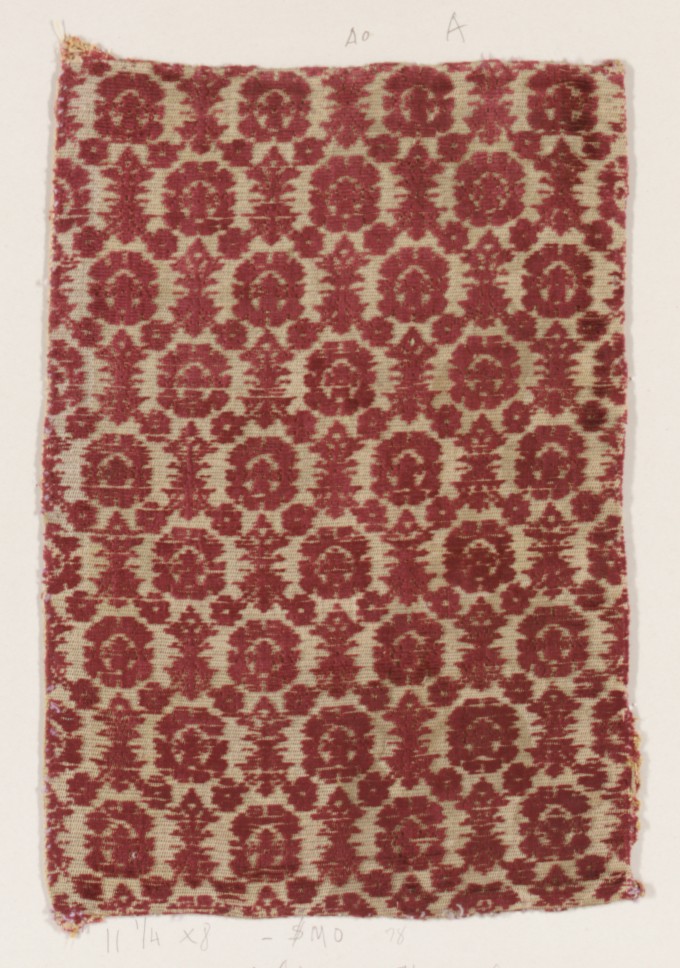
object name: fragment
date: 1701-1800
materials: metal thread, silk